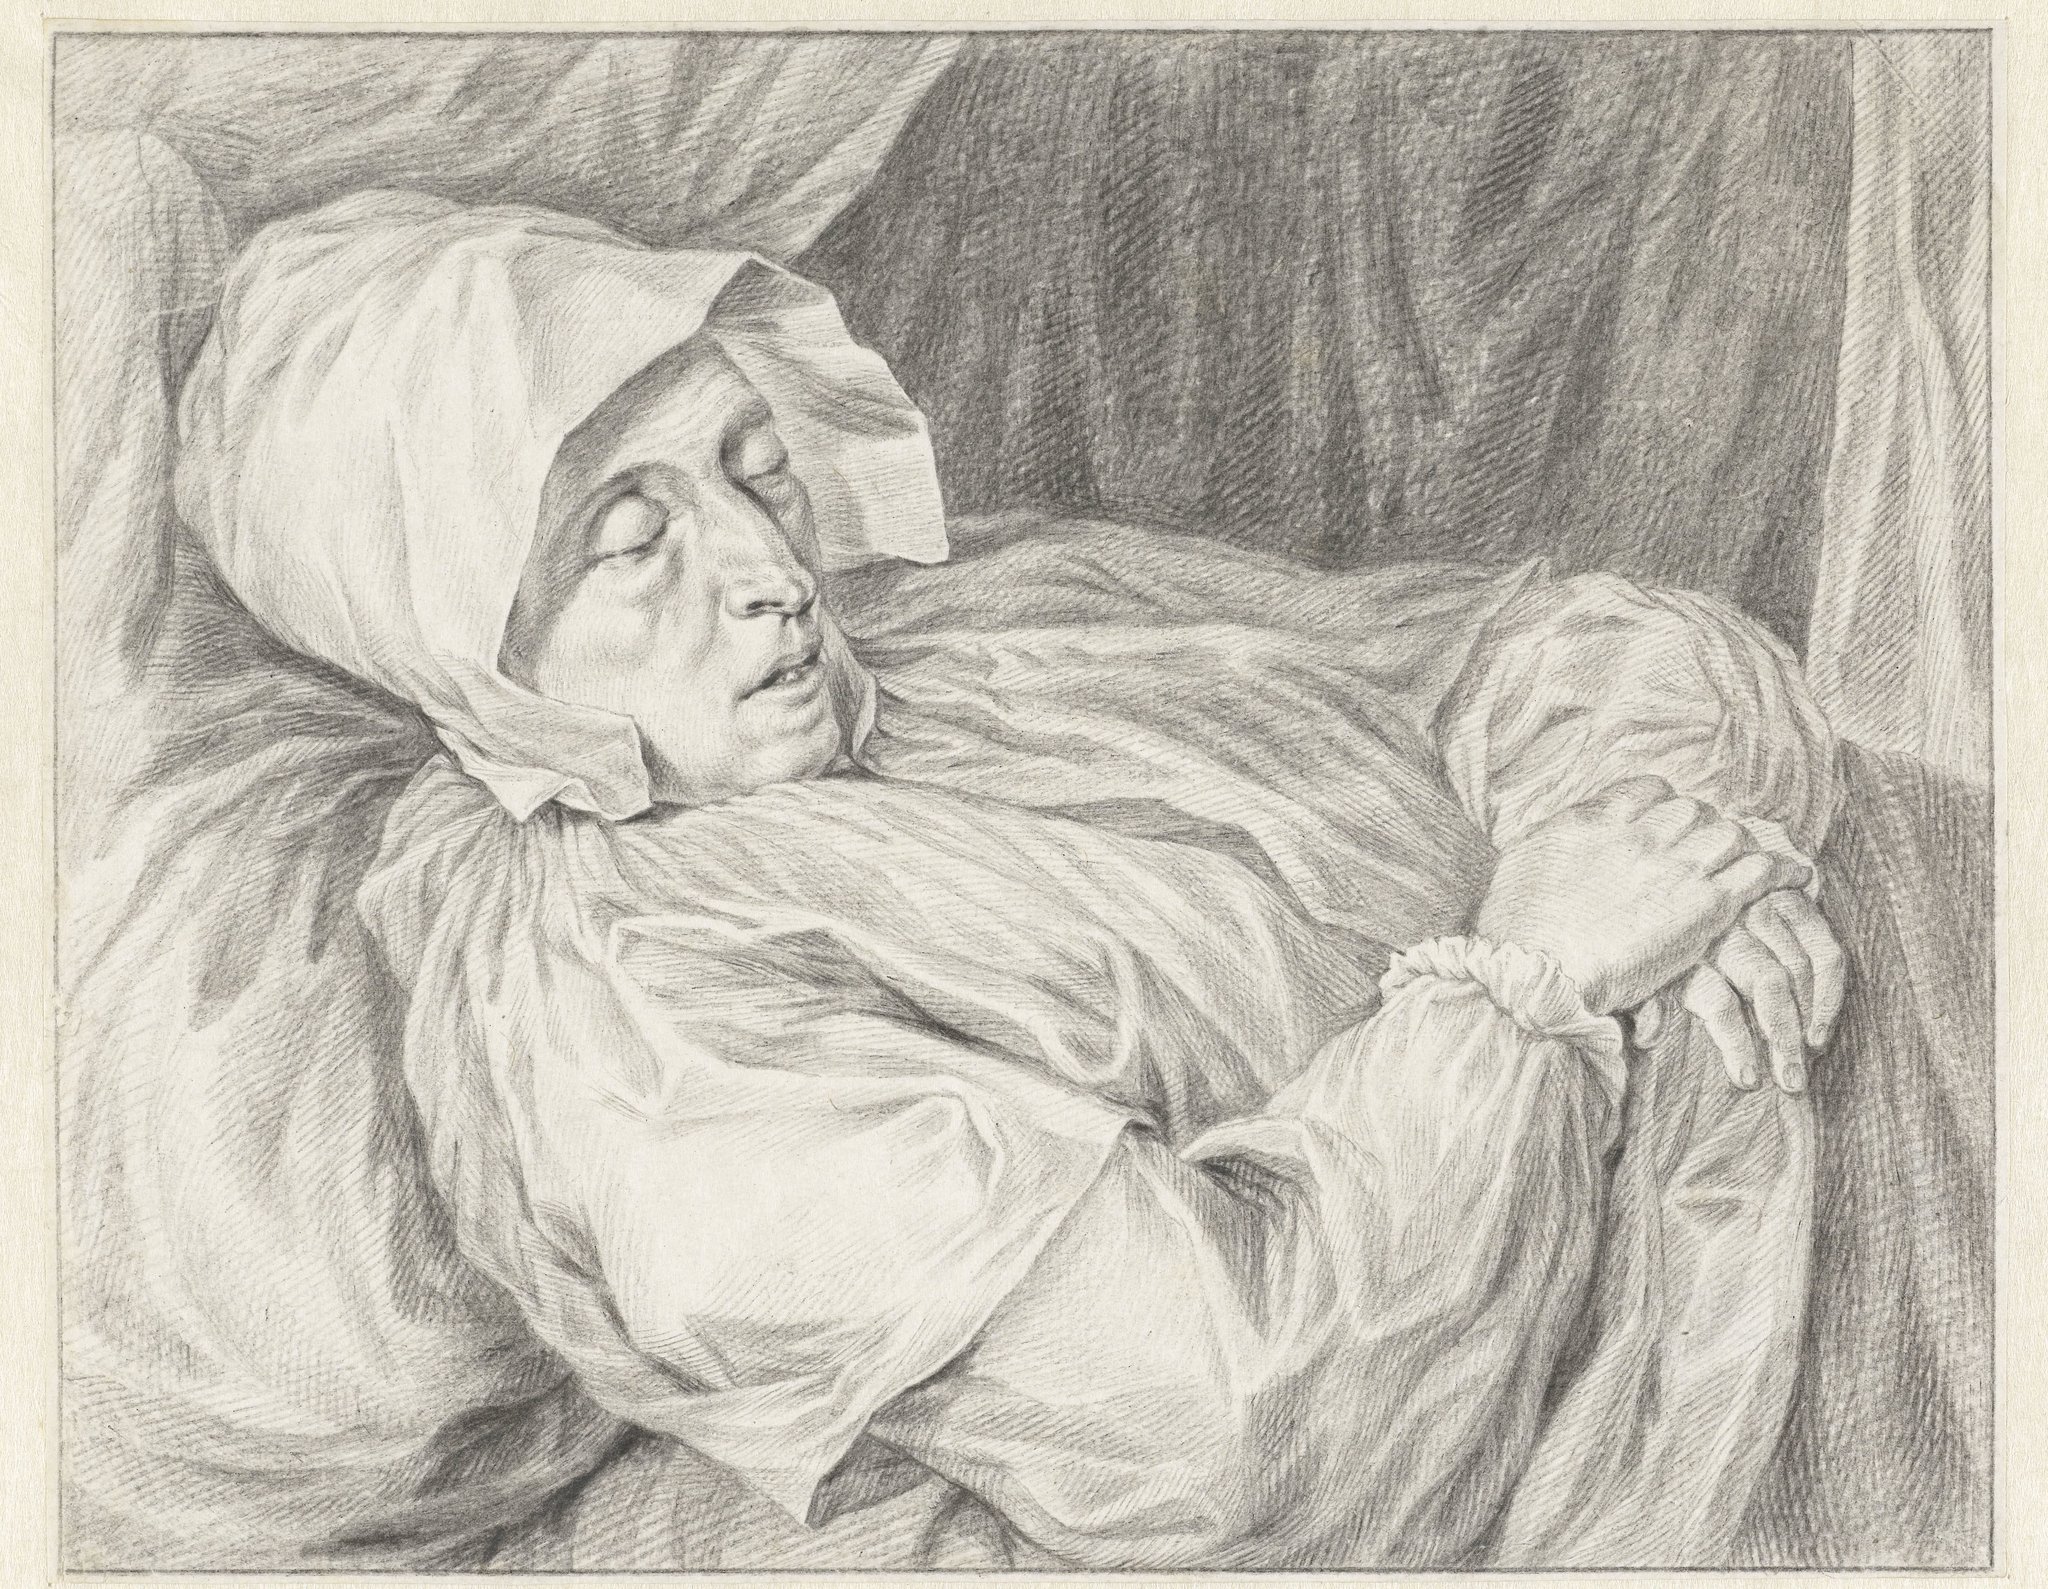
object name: drawing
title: Vrouw op haar doodsbed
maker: abraham delfos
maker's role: draughtsman, painter, print maker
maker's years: 1731-1820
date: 1777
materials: chalk, paper, pencil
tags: anonymous historical person portrayed alone (+ death-portrait)